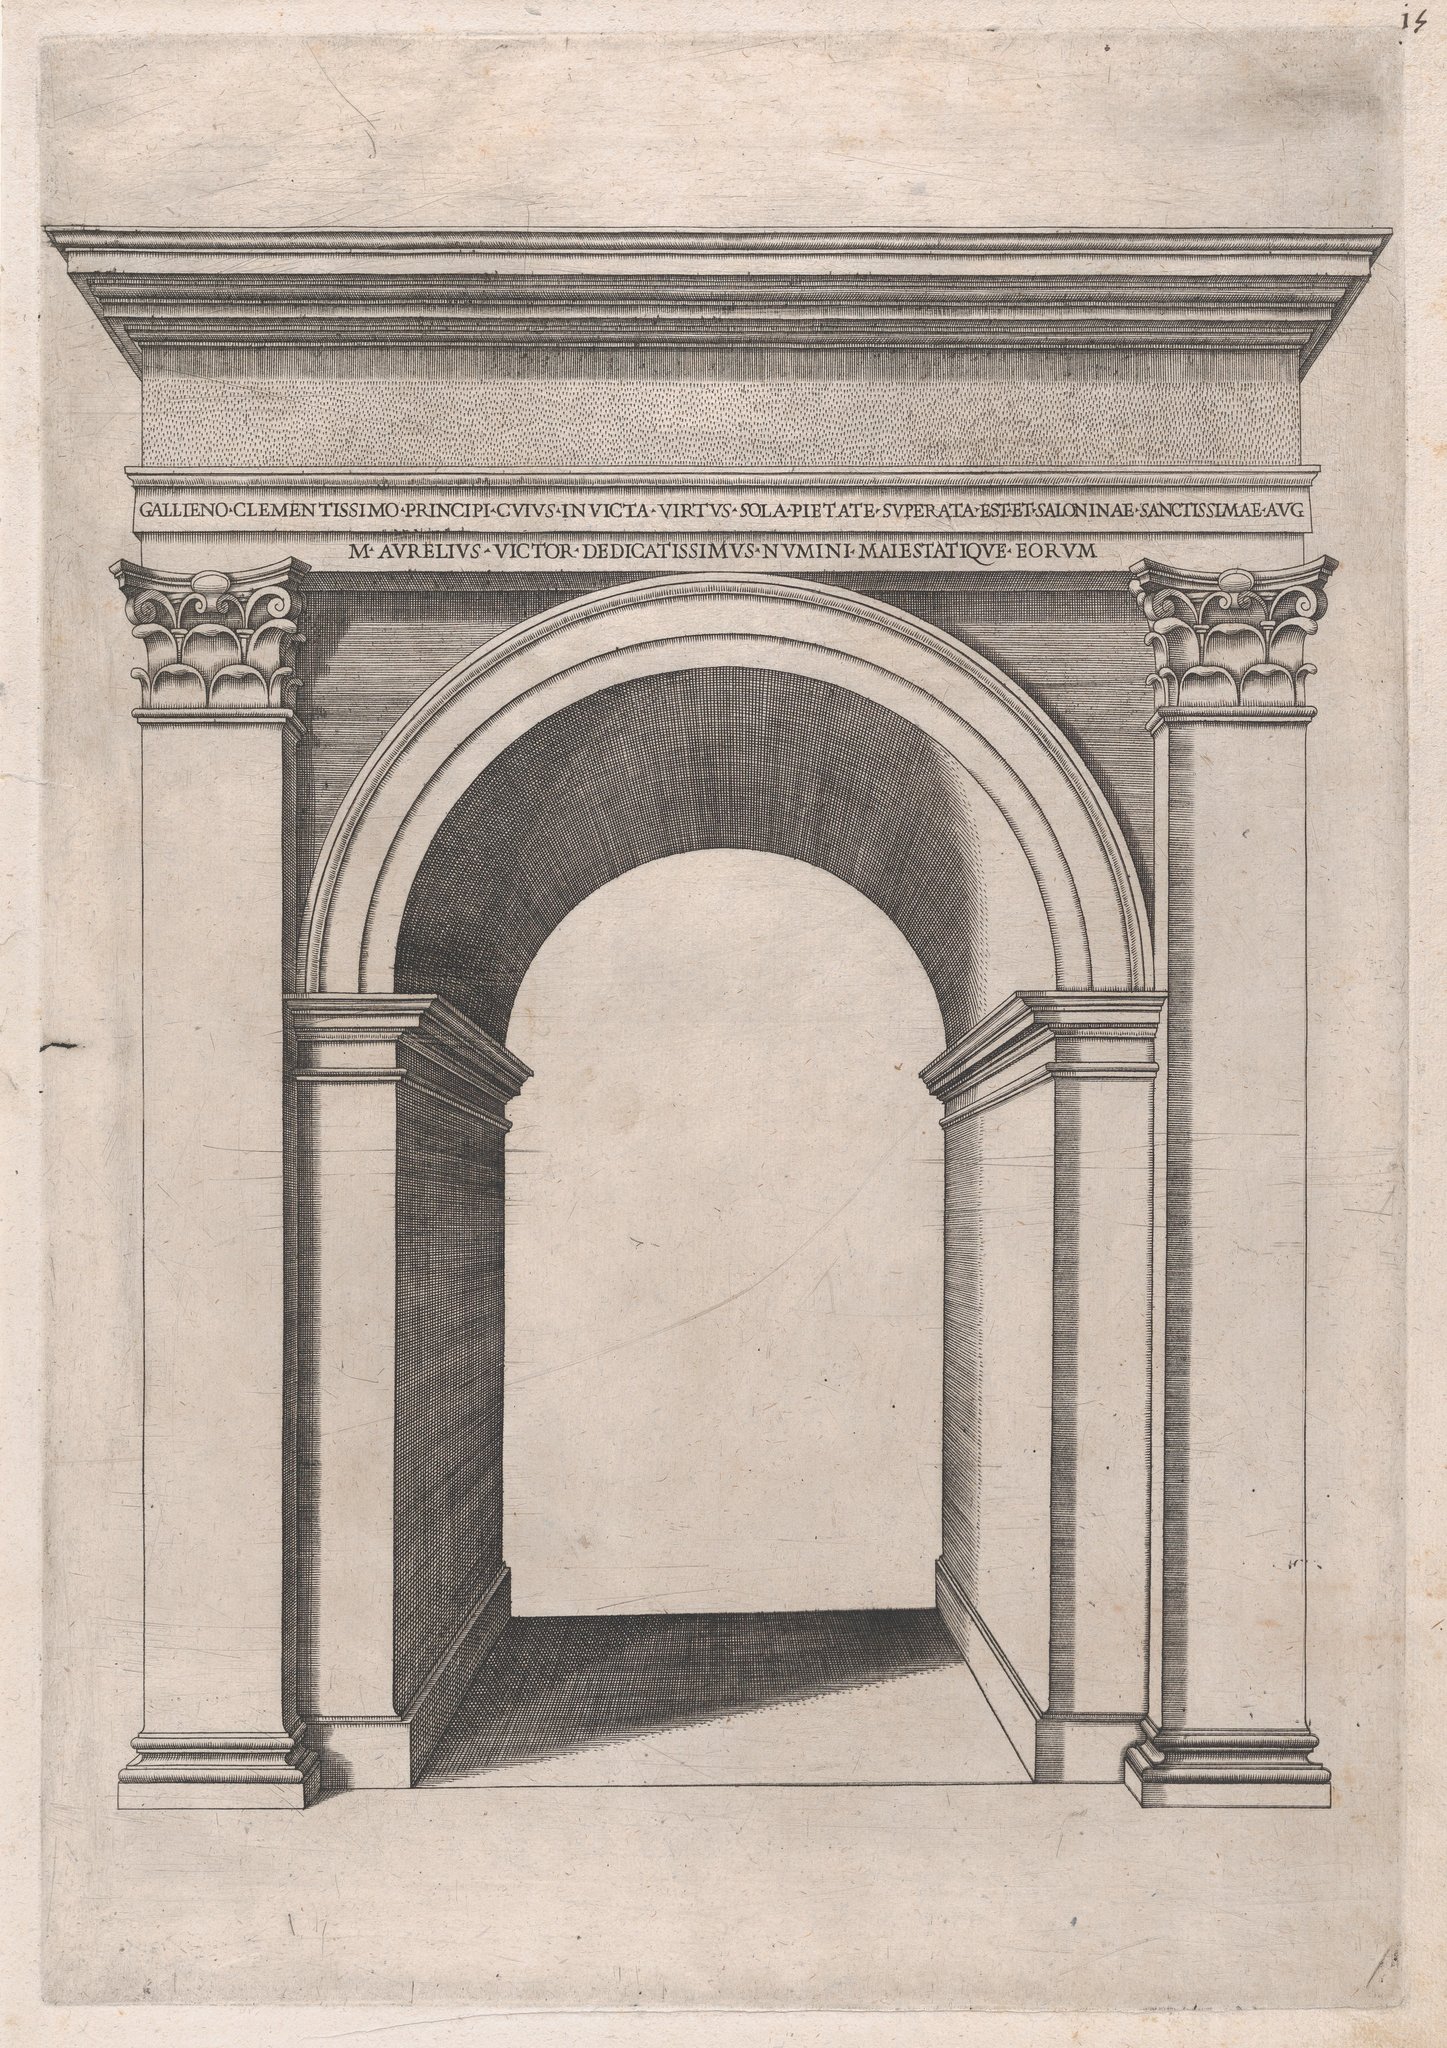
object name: print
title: Arch of Gallienus, from "Speculum Romanae Magnificentiae"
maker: Anonymous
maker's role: artist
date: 1501-1600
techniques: engraving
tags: architecture,arches,rome